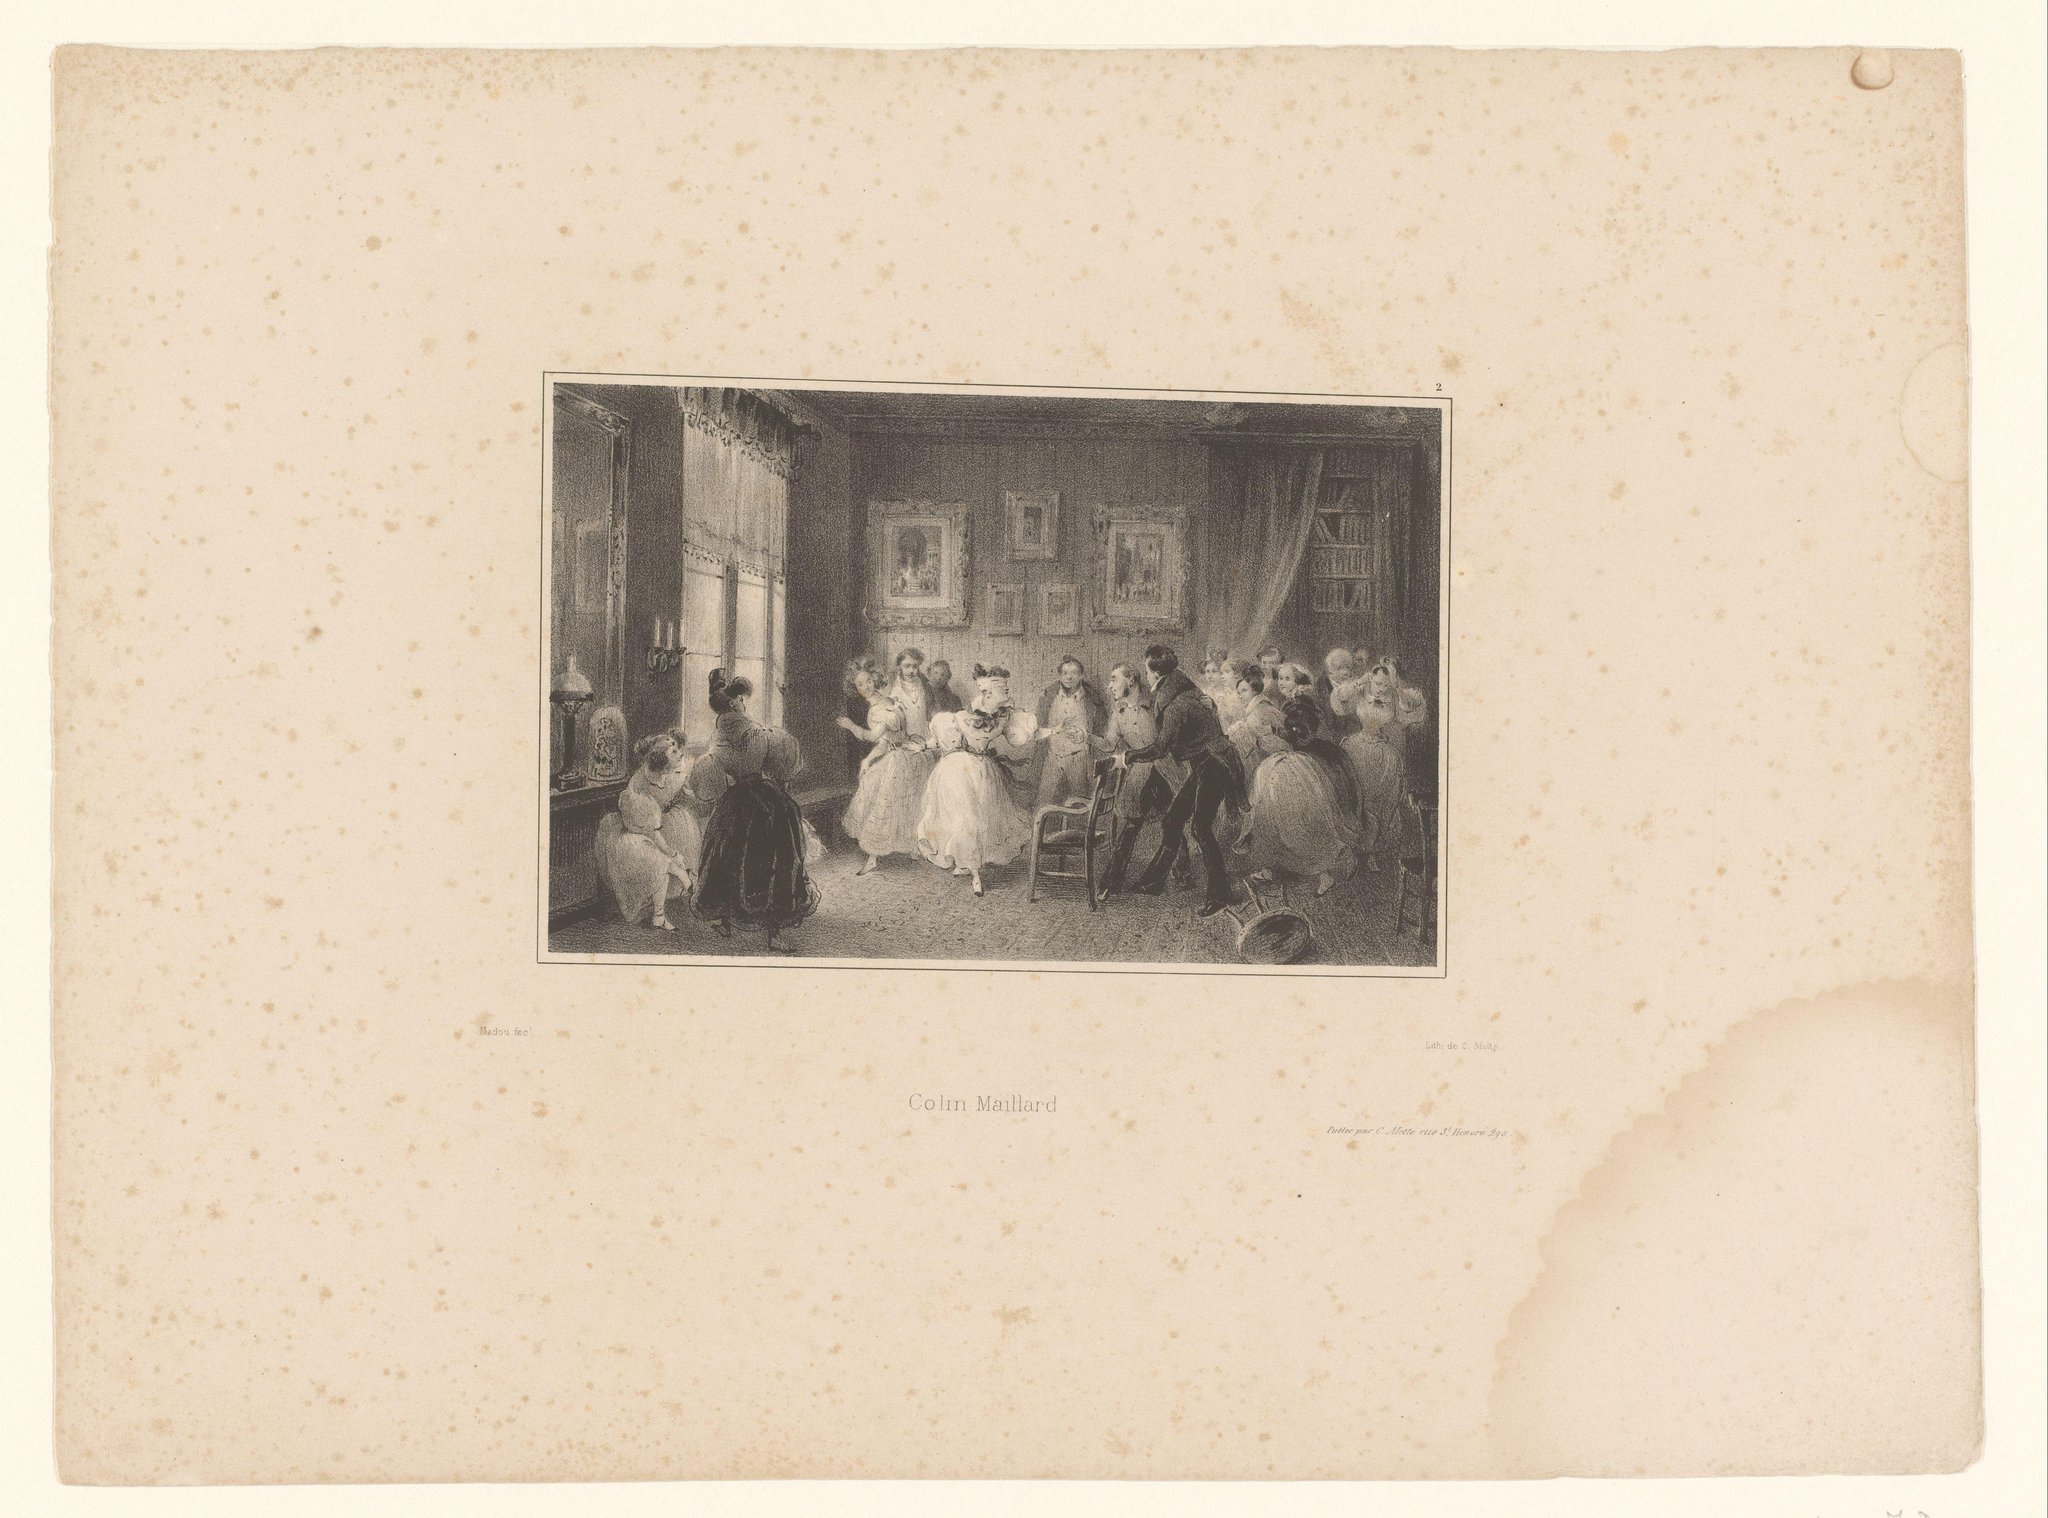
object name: print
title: Twaalf genretaferelen met vermakelijkheden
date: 1833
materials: paper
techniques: lithograph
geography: paris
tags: blindfold games, interior of the house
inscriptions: collector's mark: Lugt 2228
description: Een andere staat van deze prent is rechtsboven genummerd '8'.